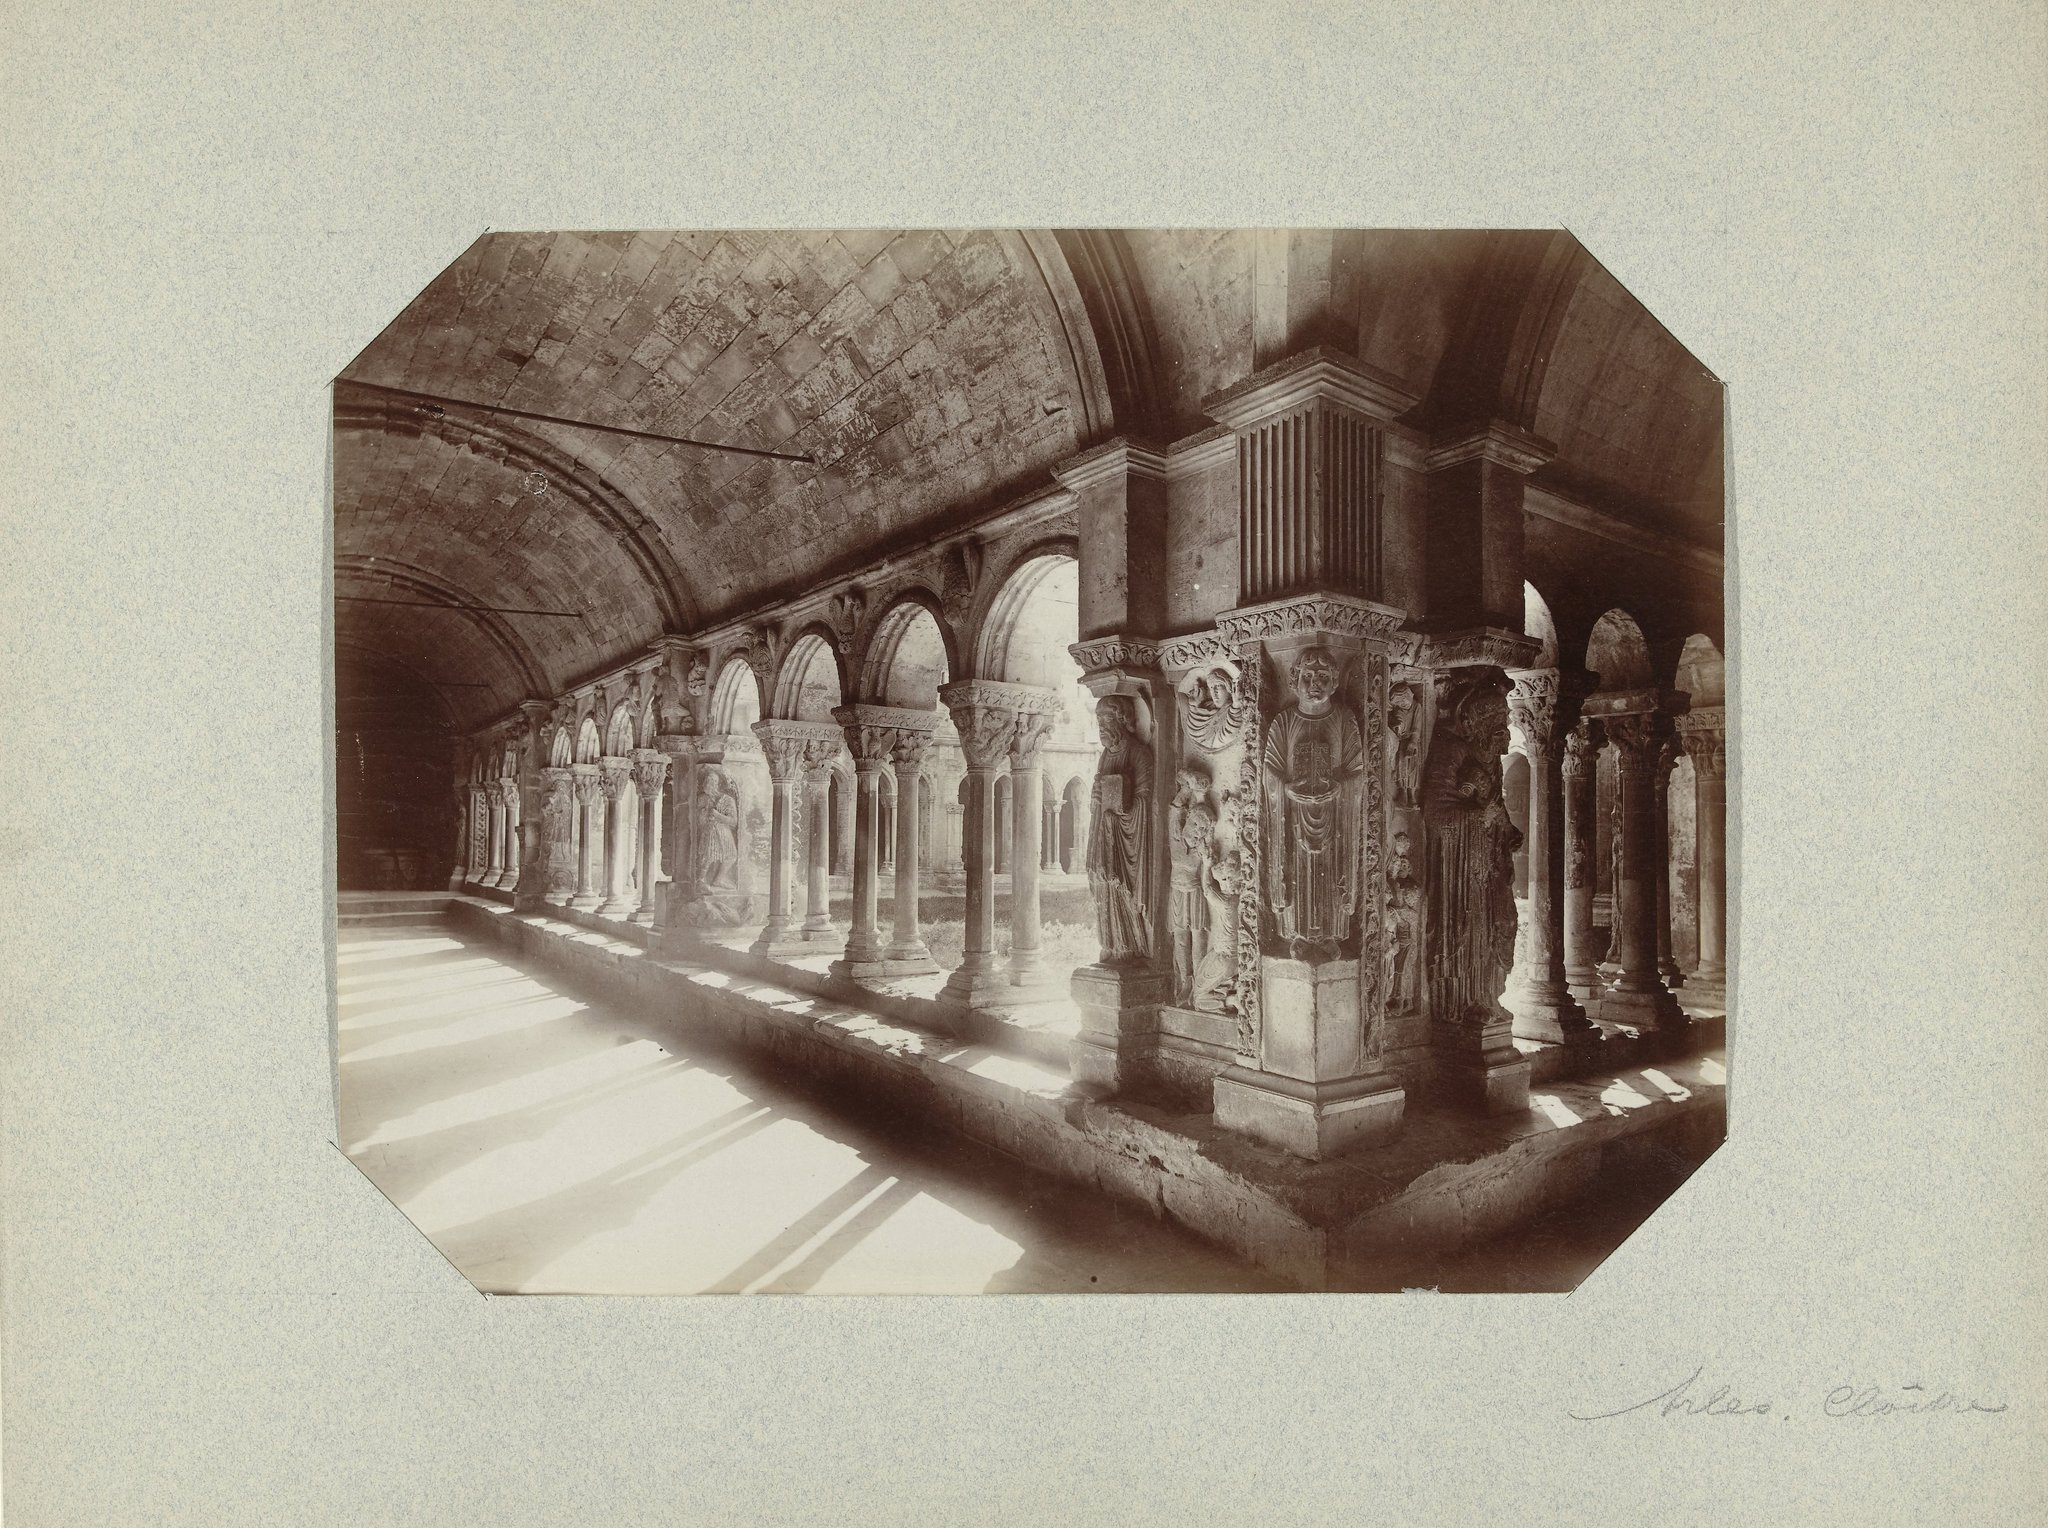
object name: photograph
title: Kloostergang van de Cathédrale Saint-Trophime in Arles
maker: Anonymous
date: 1851-1900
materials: cardboard, paper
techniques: albumen print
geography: arles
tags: cloisters ~ monastery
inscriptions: number: ‘14’, inscription: ‘Arles cloitre’